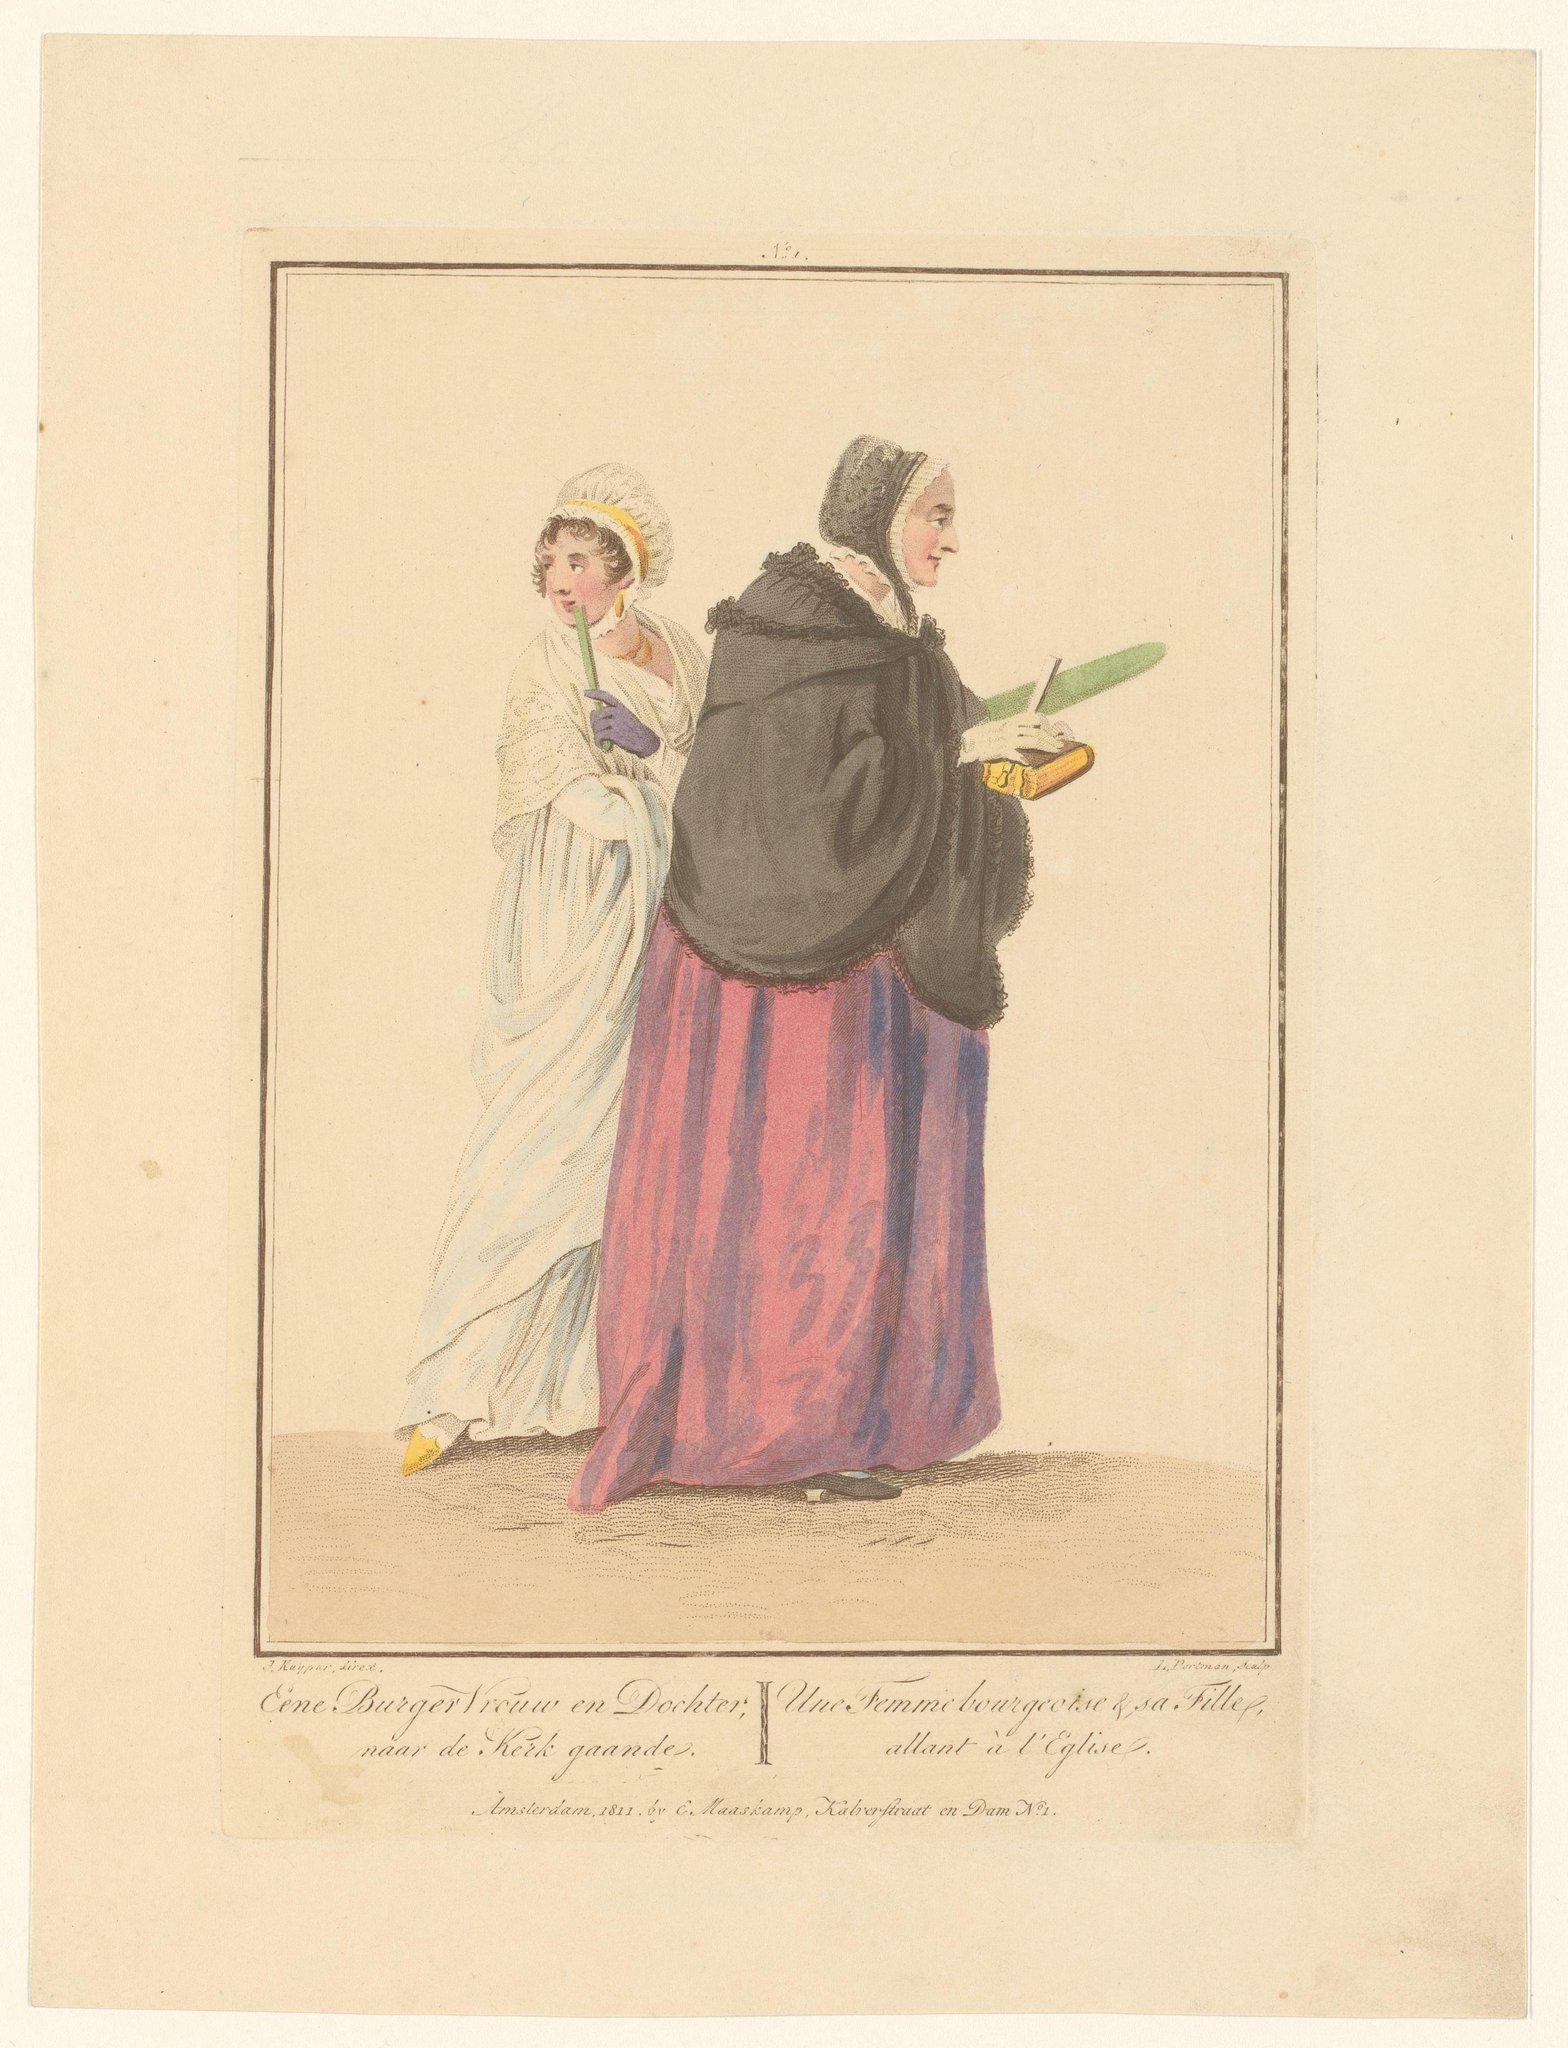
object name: book illustration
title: Een Burger Vrouw en Dochter, naar de Kerk gaande / Une Femme bourgeoise & sa Fille, allant à l'Eglise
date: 1811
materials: paper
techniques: engraving, etching, hand coloring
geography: amsterdam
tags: going to church, fan, clothes, costume, the bible as a book, batavian republic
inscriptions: date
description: Prent waarschijnlijk uit: Maaskamp, Evert. Afbeeldingen van de kleeding, zeden en gewoonten in de Bataafsche Republiek (...). Amsterdam: Evert Maaskamp, 1811. Prent in eerdere staat gebruikt in eerdere publicatie. Mogelijk ook gebruikt in heruitgave uit 1829.